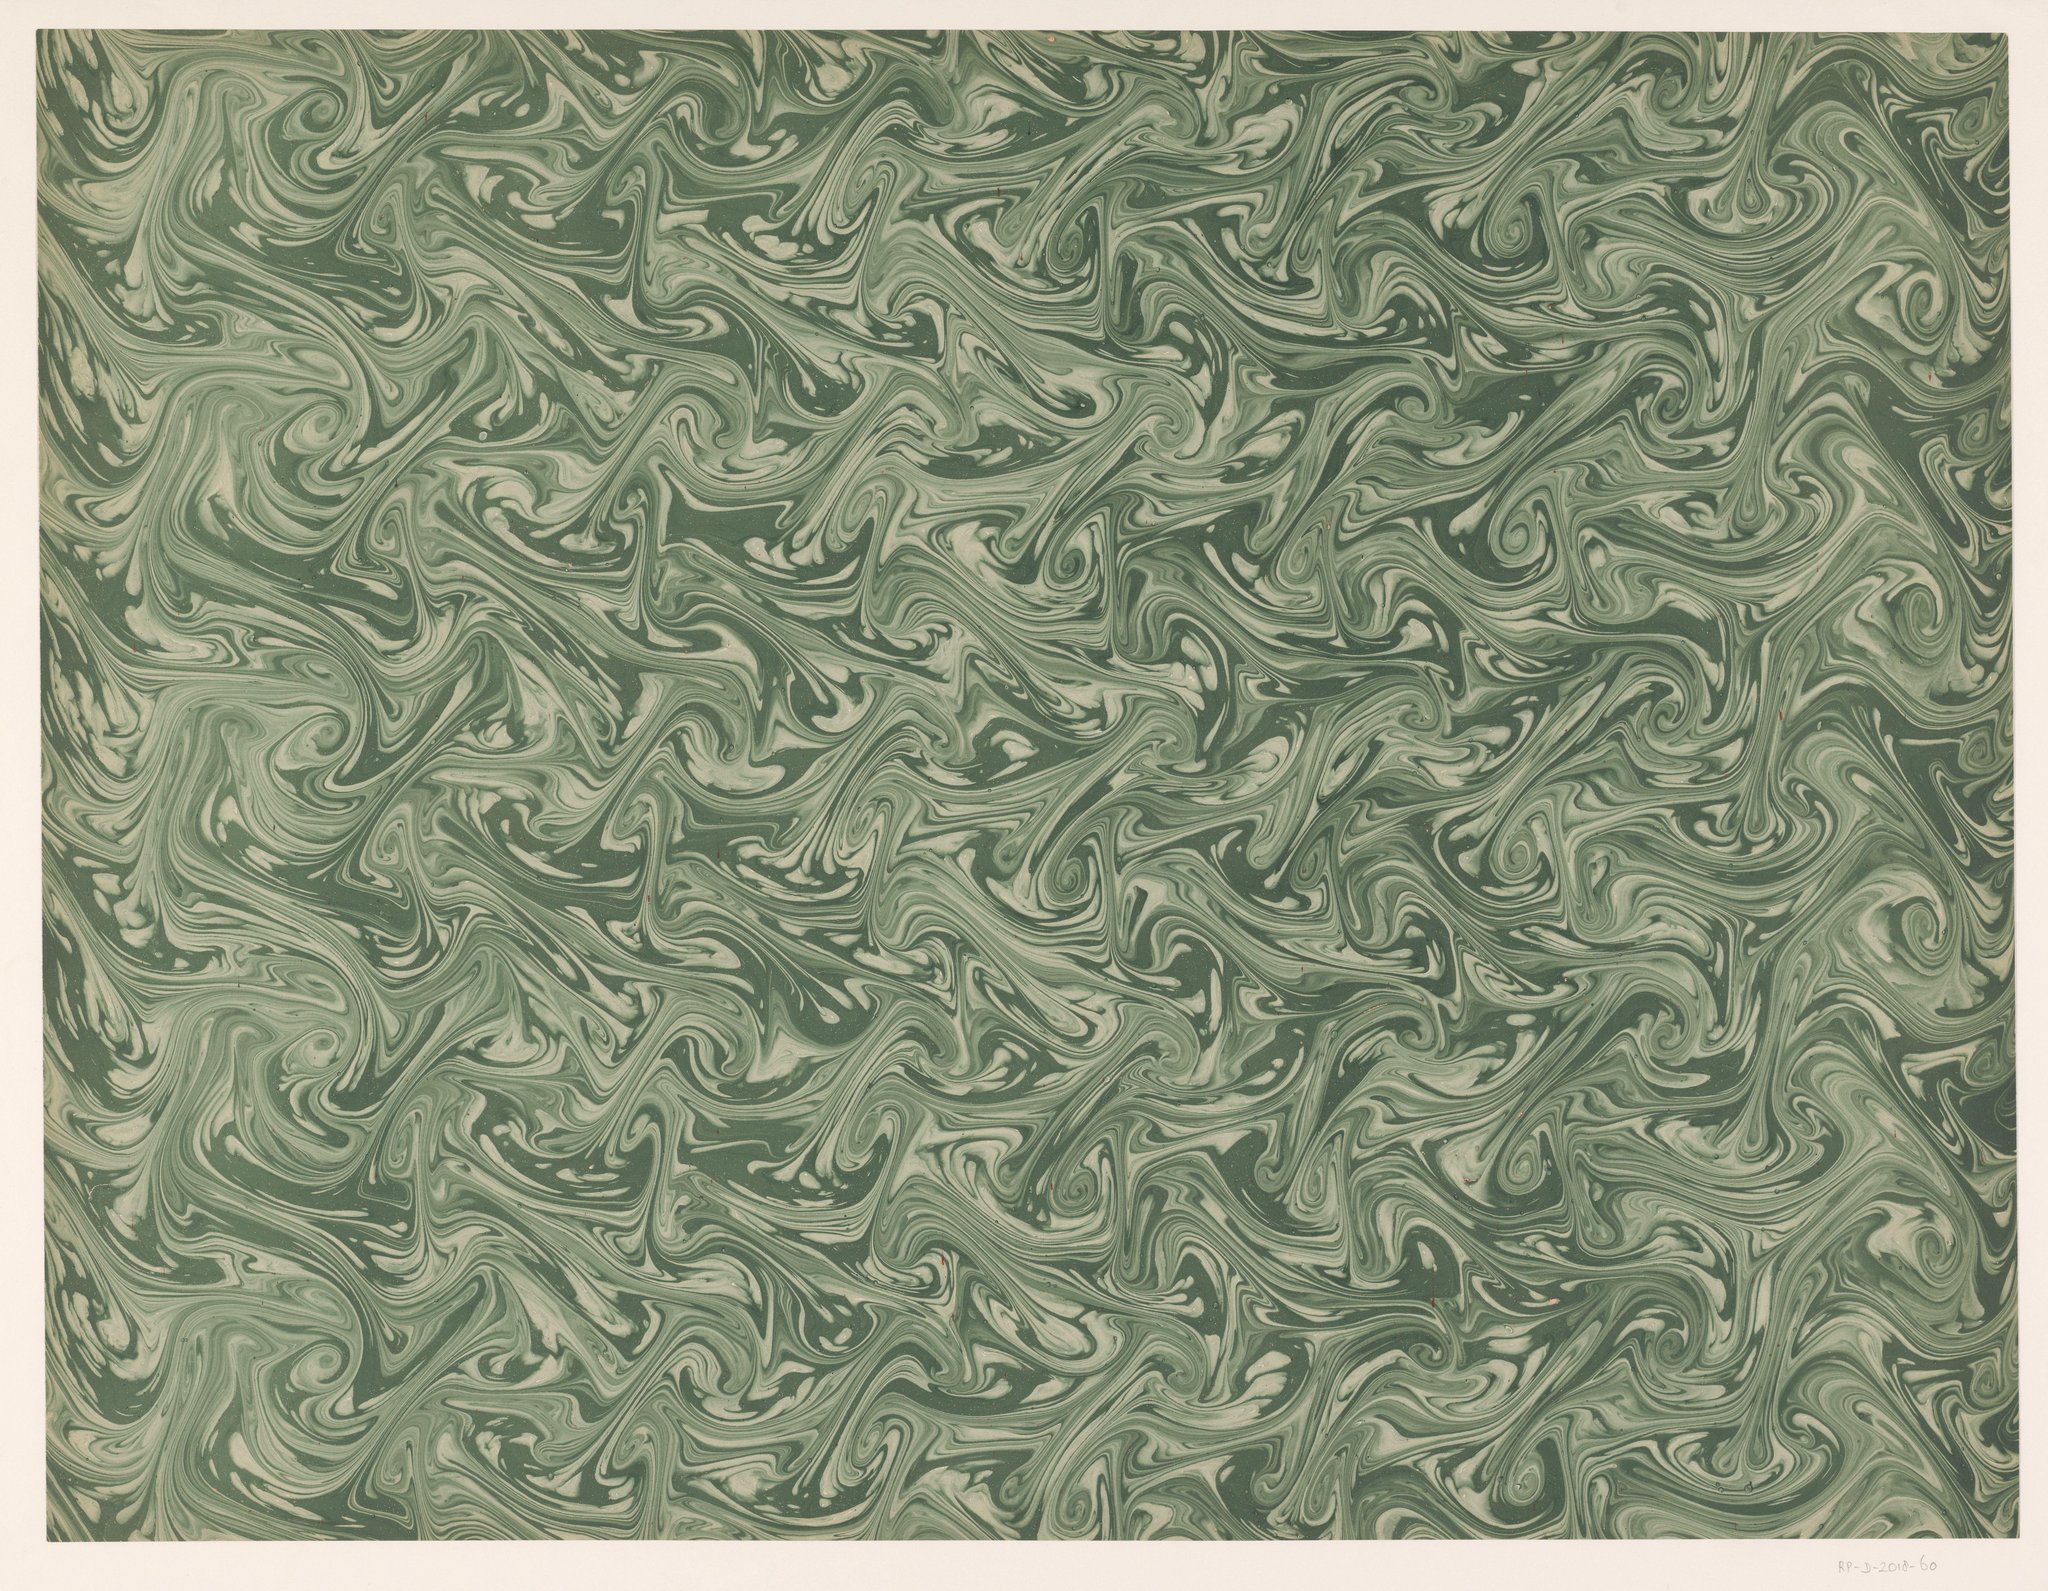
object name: marbled paper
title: Fantasiemarmer in twee tinten groen en wit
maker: Anonymous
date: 1900-2000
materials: paint, paper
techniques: marbled paper